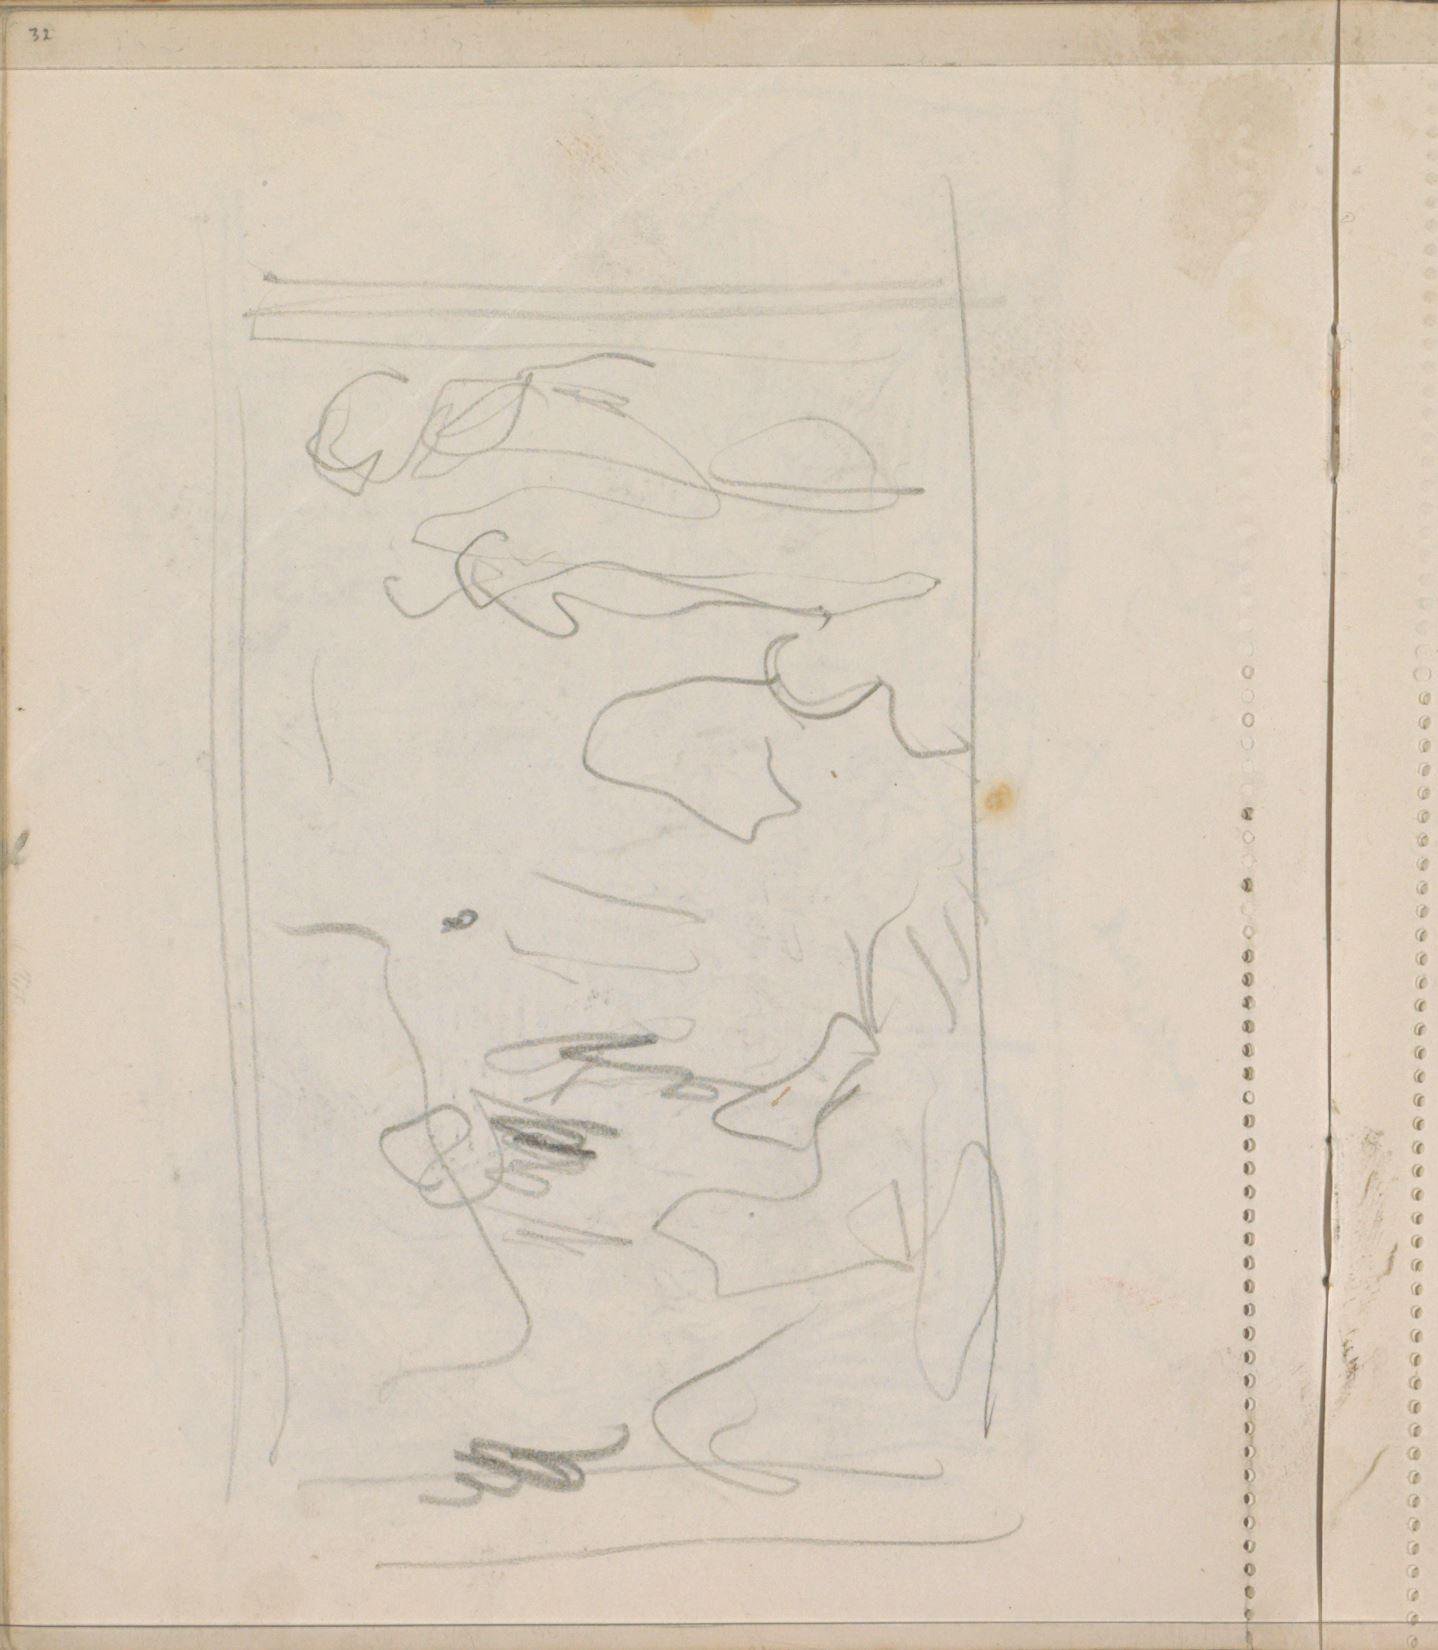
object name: sketchbook leaf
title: Studie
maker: marius bauer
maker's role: draughtsman, print maker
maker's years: 1867-1932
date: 1925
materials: paper, pencil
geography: indonesia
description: Pagina 32 uit een schetsboek met 67 bladen.